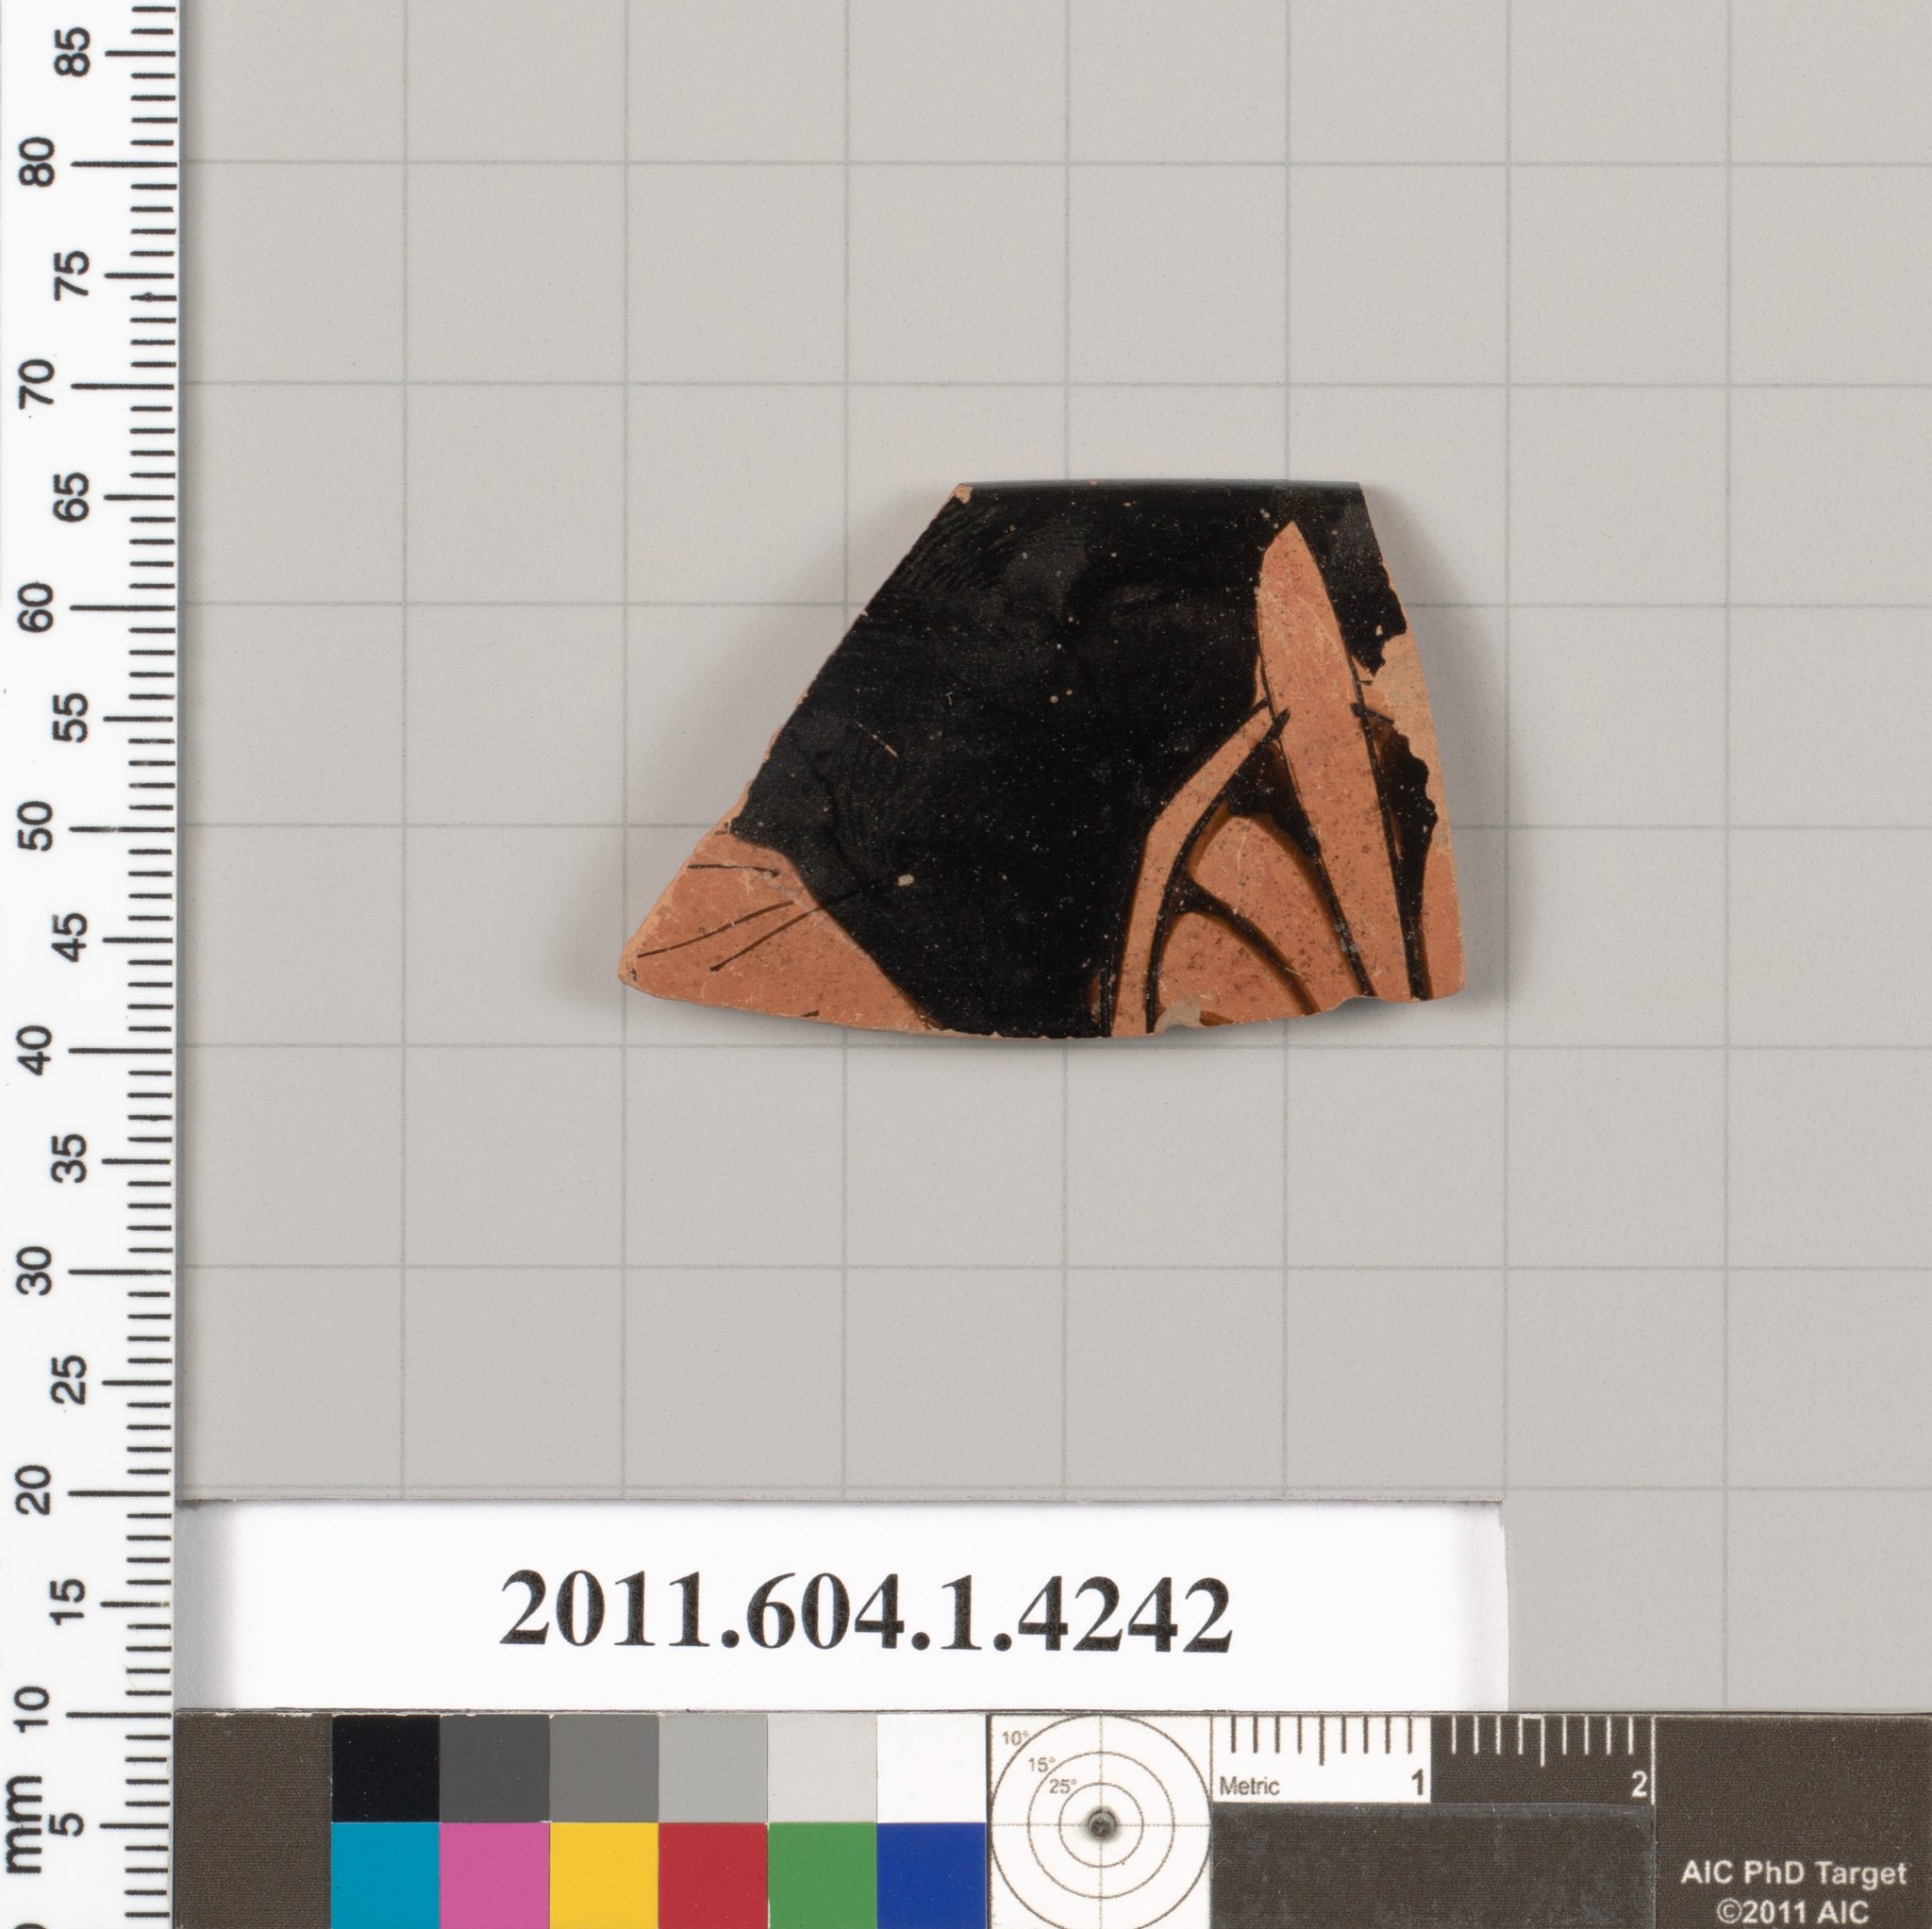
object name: kylix fragment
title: Terracotta rim fragment of a kylix (drinking cup)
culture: greek, attic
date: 467-435 BCE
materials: terracotta